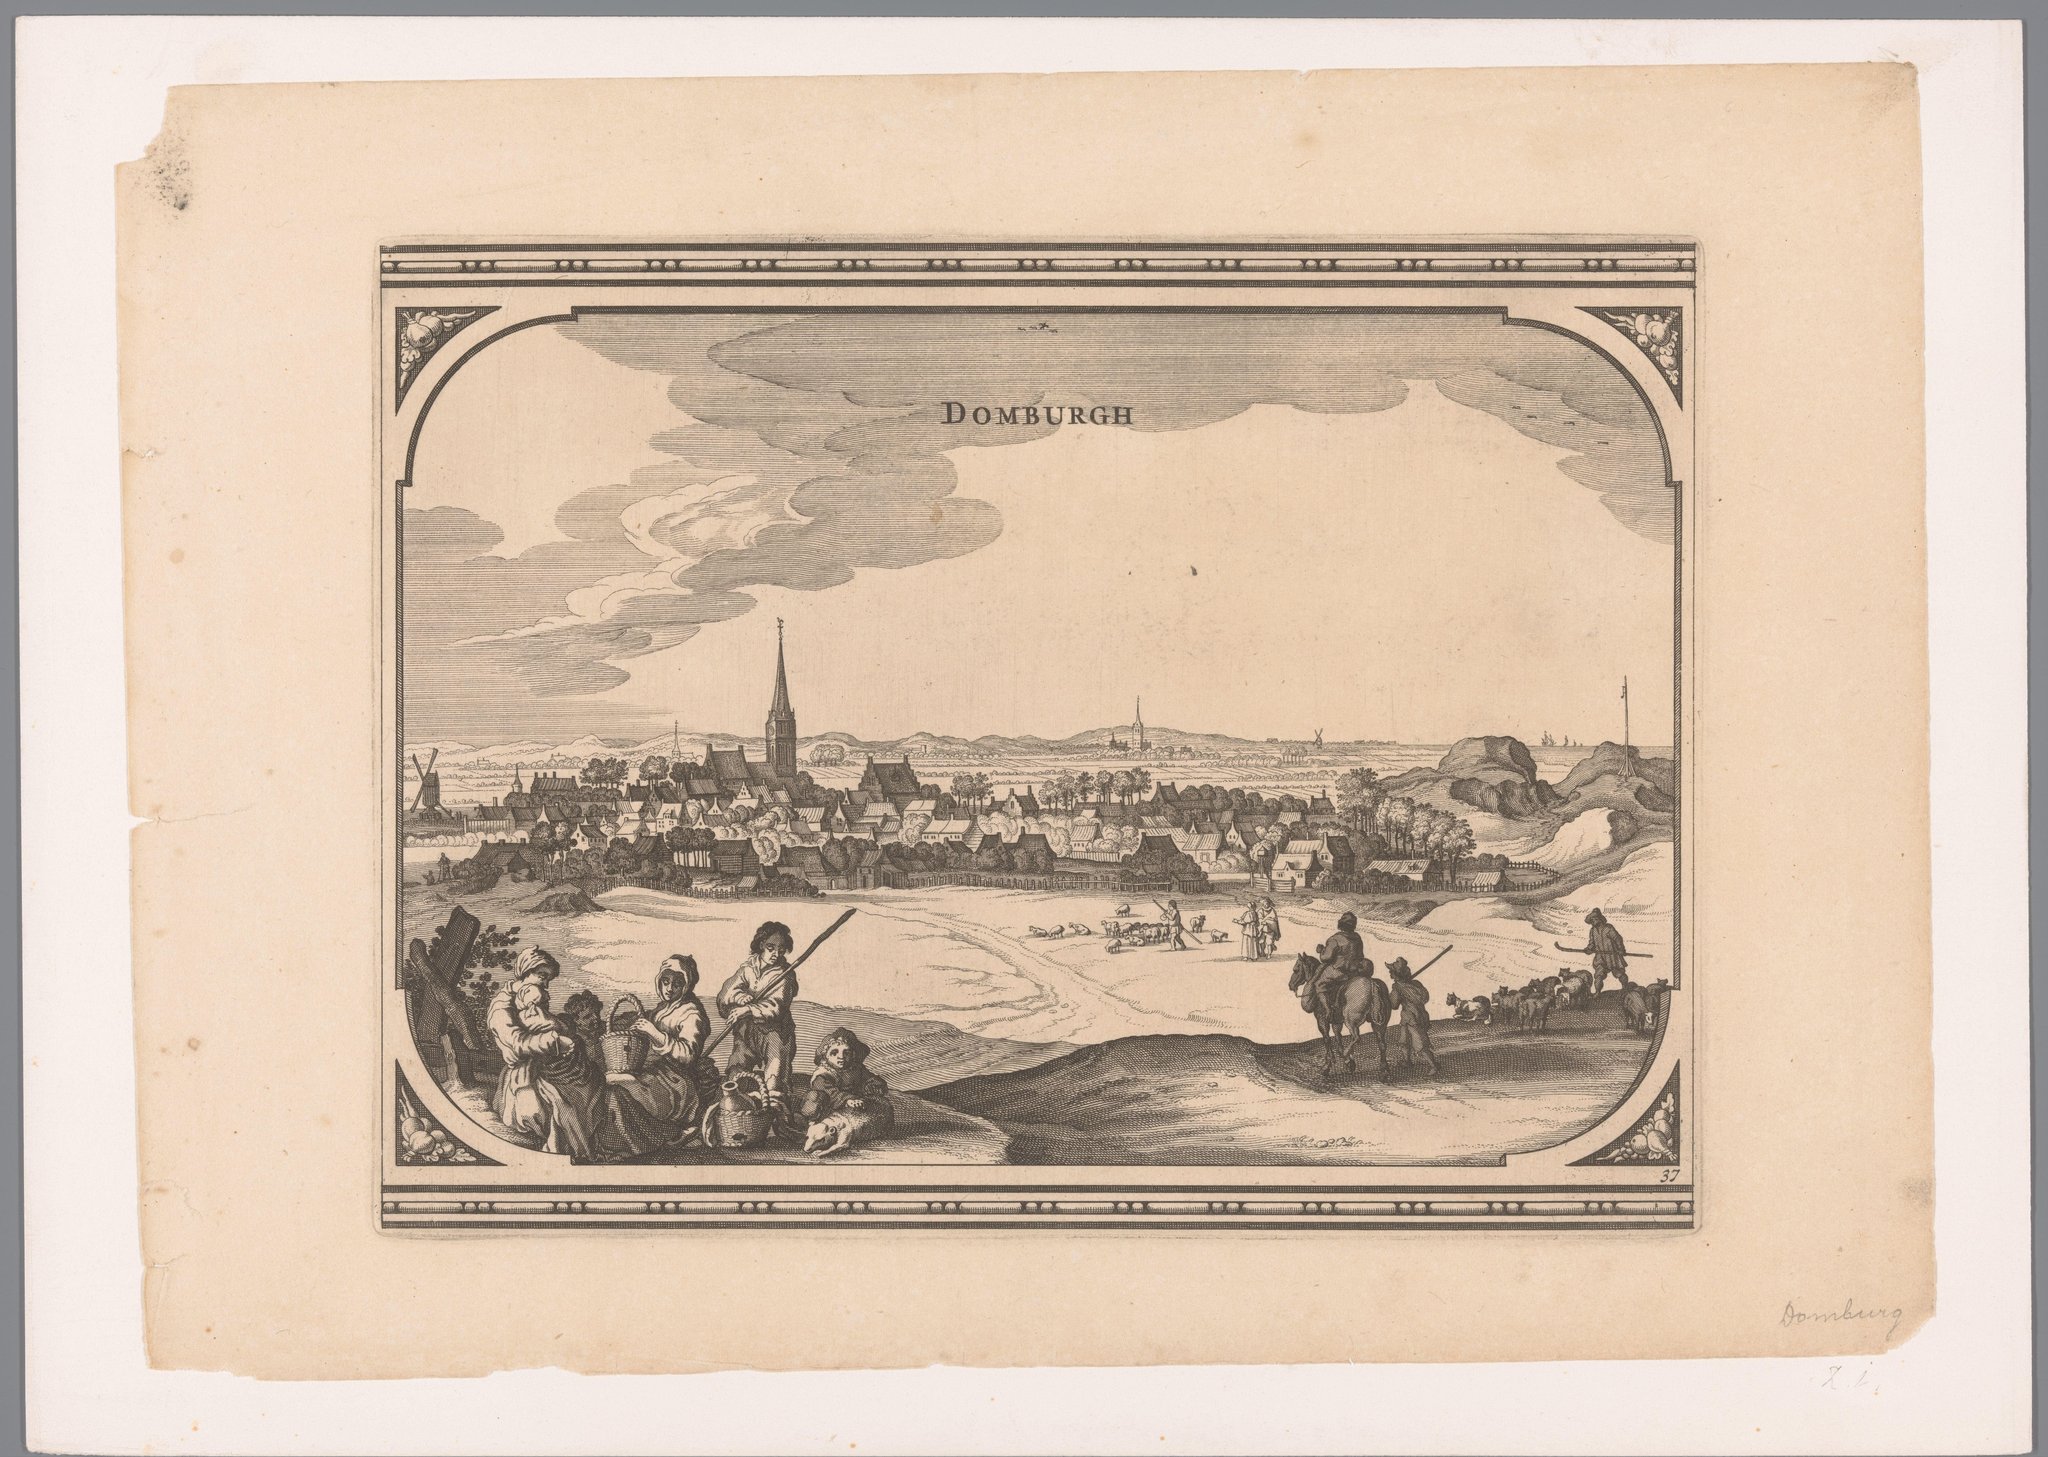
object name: print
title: Gezicht op Domburg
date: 1656-1657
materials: paper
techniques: engraving, etching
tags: prospect of village, silhouette of village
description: Prent verschenen in: Theatrum praecipuarum urbium ducatus Brababtiae necnon comitatum Flandriae et Zelandiae. Amsterdam: Nicolaes Visscher, 1657. En in: Schut, Pieter Hendricksz.Theatrum praecipuarum urbium ducatus Brababtiae necnon comitatum Flandriae et Zelandiae. Amsterdam: Nicolaes Visscher, 1657. En in: Caerten en Steden van Brabant, Vlaenderen ende Zeelandt, Middelburg. Middelburg: Zacharias Roman, Amsterdam: Nicolaes Visscher, 1656. Verschillende staten van prenten zijn gebruikt in uitgaven van 'Speculum Zelandiae' en in andere publicaties uitgegeven door Zacharias Roman en Nicolaes Visscher (I). Verwarring rondom de datering kan ontstaan door het feit dat de prenten uit 'Speculum Zelandiae' ook voorkomen in eerder uitgegeven publicaties, waar ze later in zijn ingebonden. Zo komen prenten uitgegeven door Roman/Visscher voor in sommige exemplaren van: Boxhorn, Marcus Zuerius van. Chroniick van Zeelandt (…). 2 dln. Middelburg: Zacharias Roman, 1644. De door weduwe (Joachim) Ottens en Zoonen uitgegeven prenten zijn later ingebonden in sommige exemplaren van: Smallegange, Mattheus. Nieuwe Cronyk van Zeeland (…). Middelburg en Amsterdam: Johannes Meertens en Abraham van Someren, 1696.